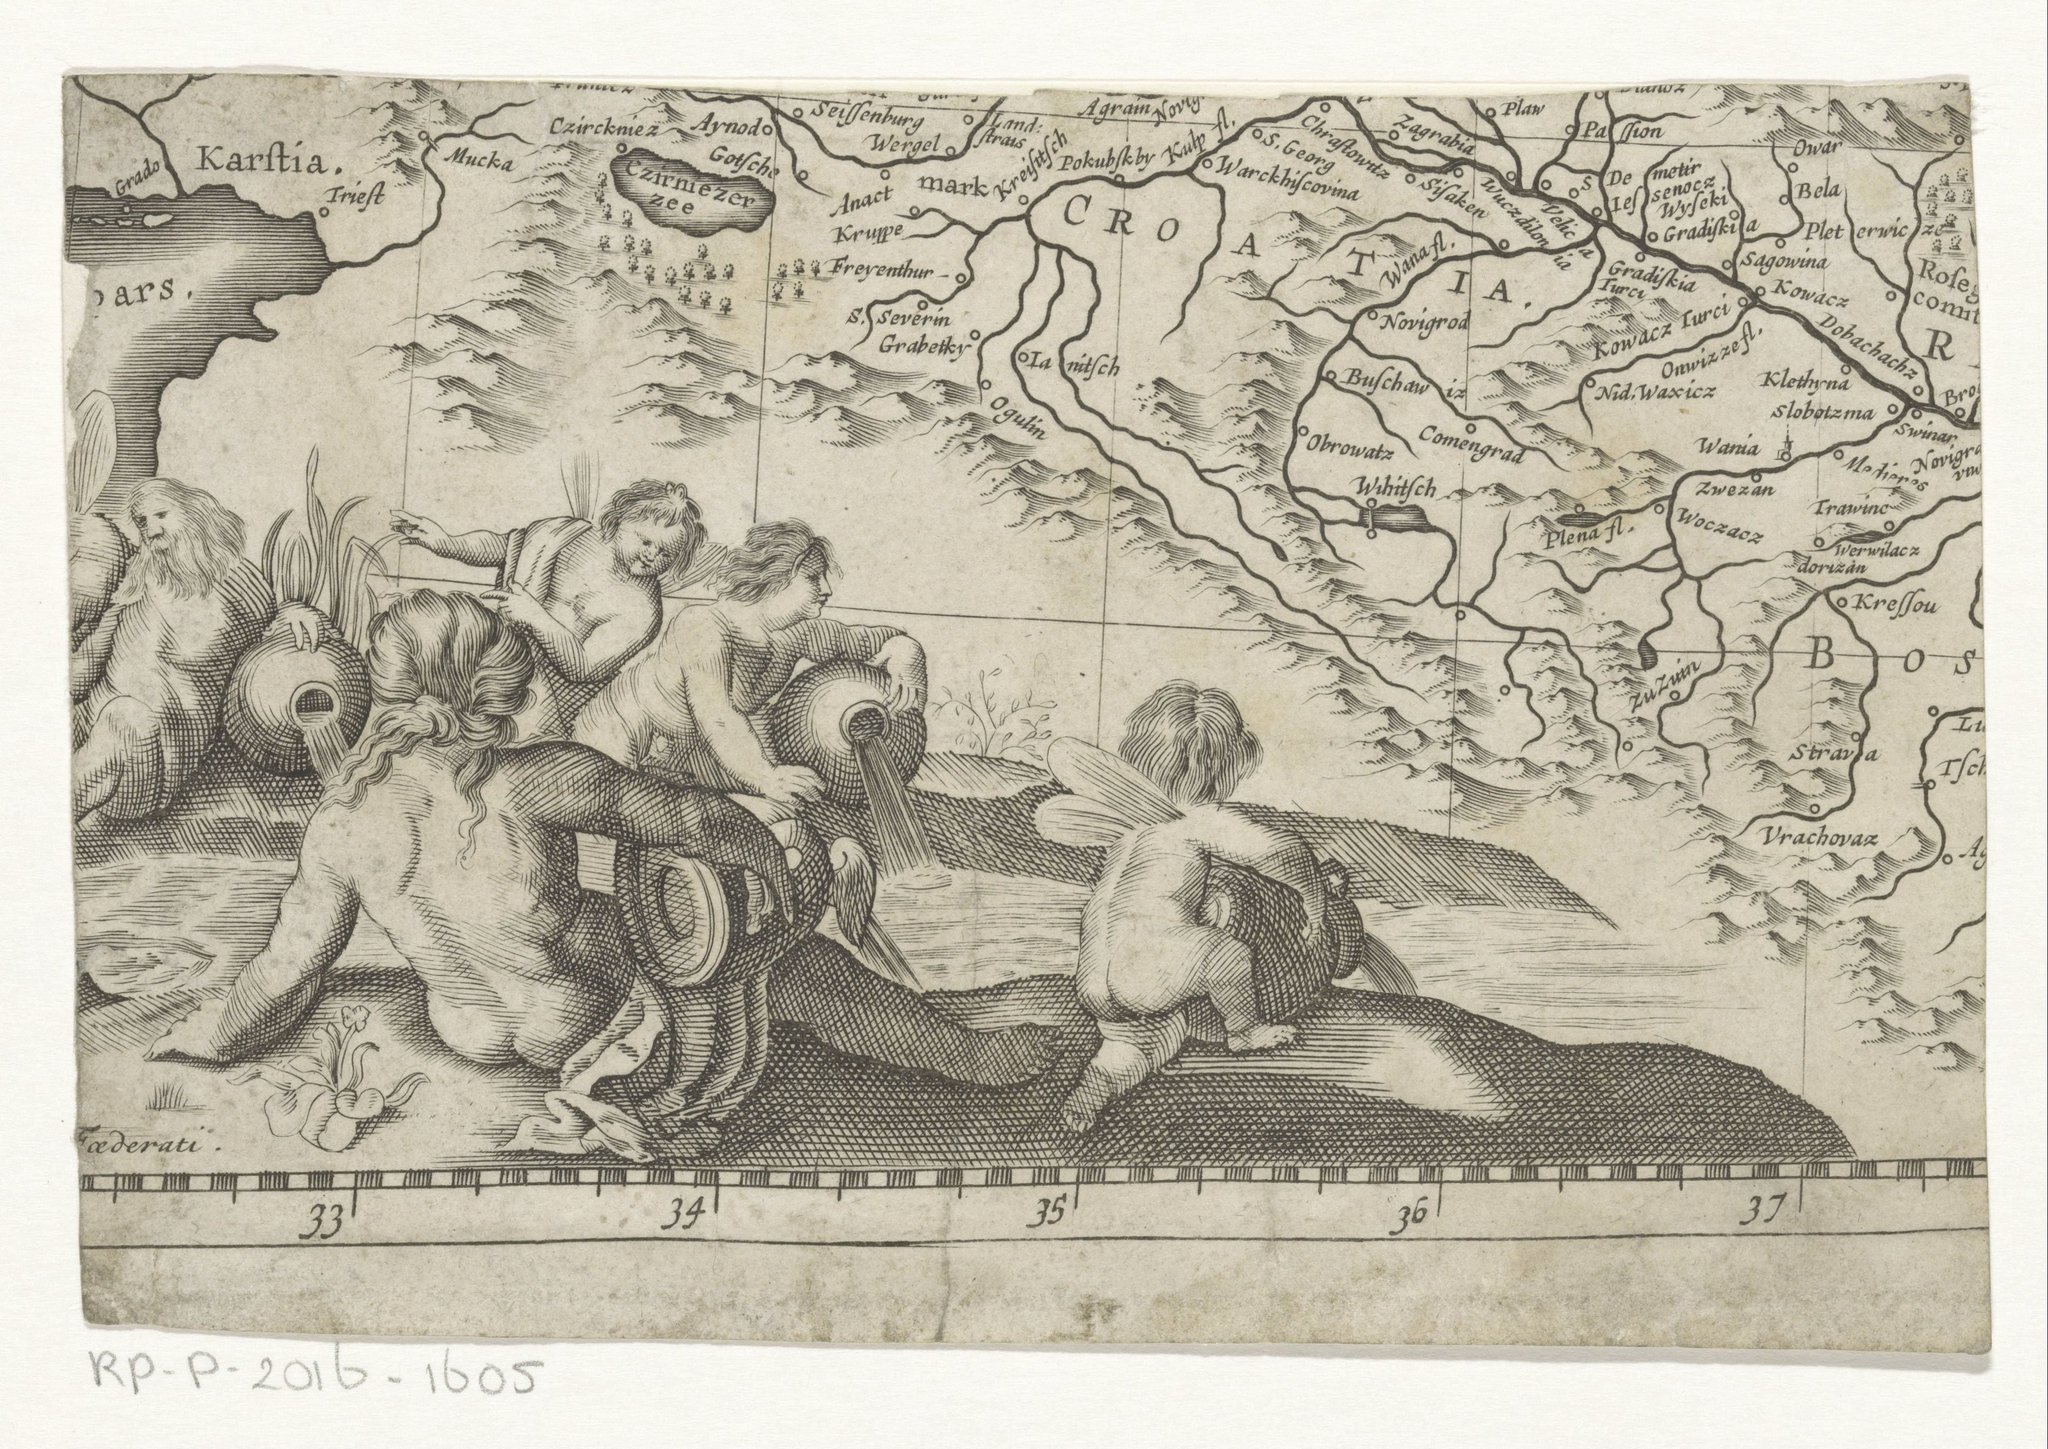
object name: print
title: Riviergoden en putti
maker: Anonymous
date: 1700-1800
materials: paper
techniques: engraving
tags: river-gods, cupids: 'amores', 'amoretti', 'putti'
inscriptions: collector's mark: Lugt 2228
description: Langs een rivier zitten drie riviergoden en putti met waterkruiken. Detail van een onbekende kaart, waarop onder andere Kroatië.